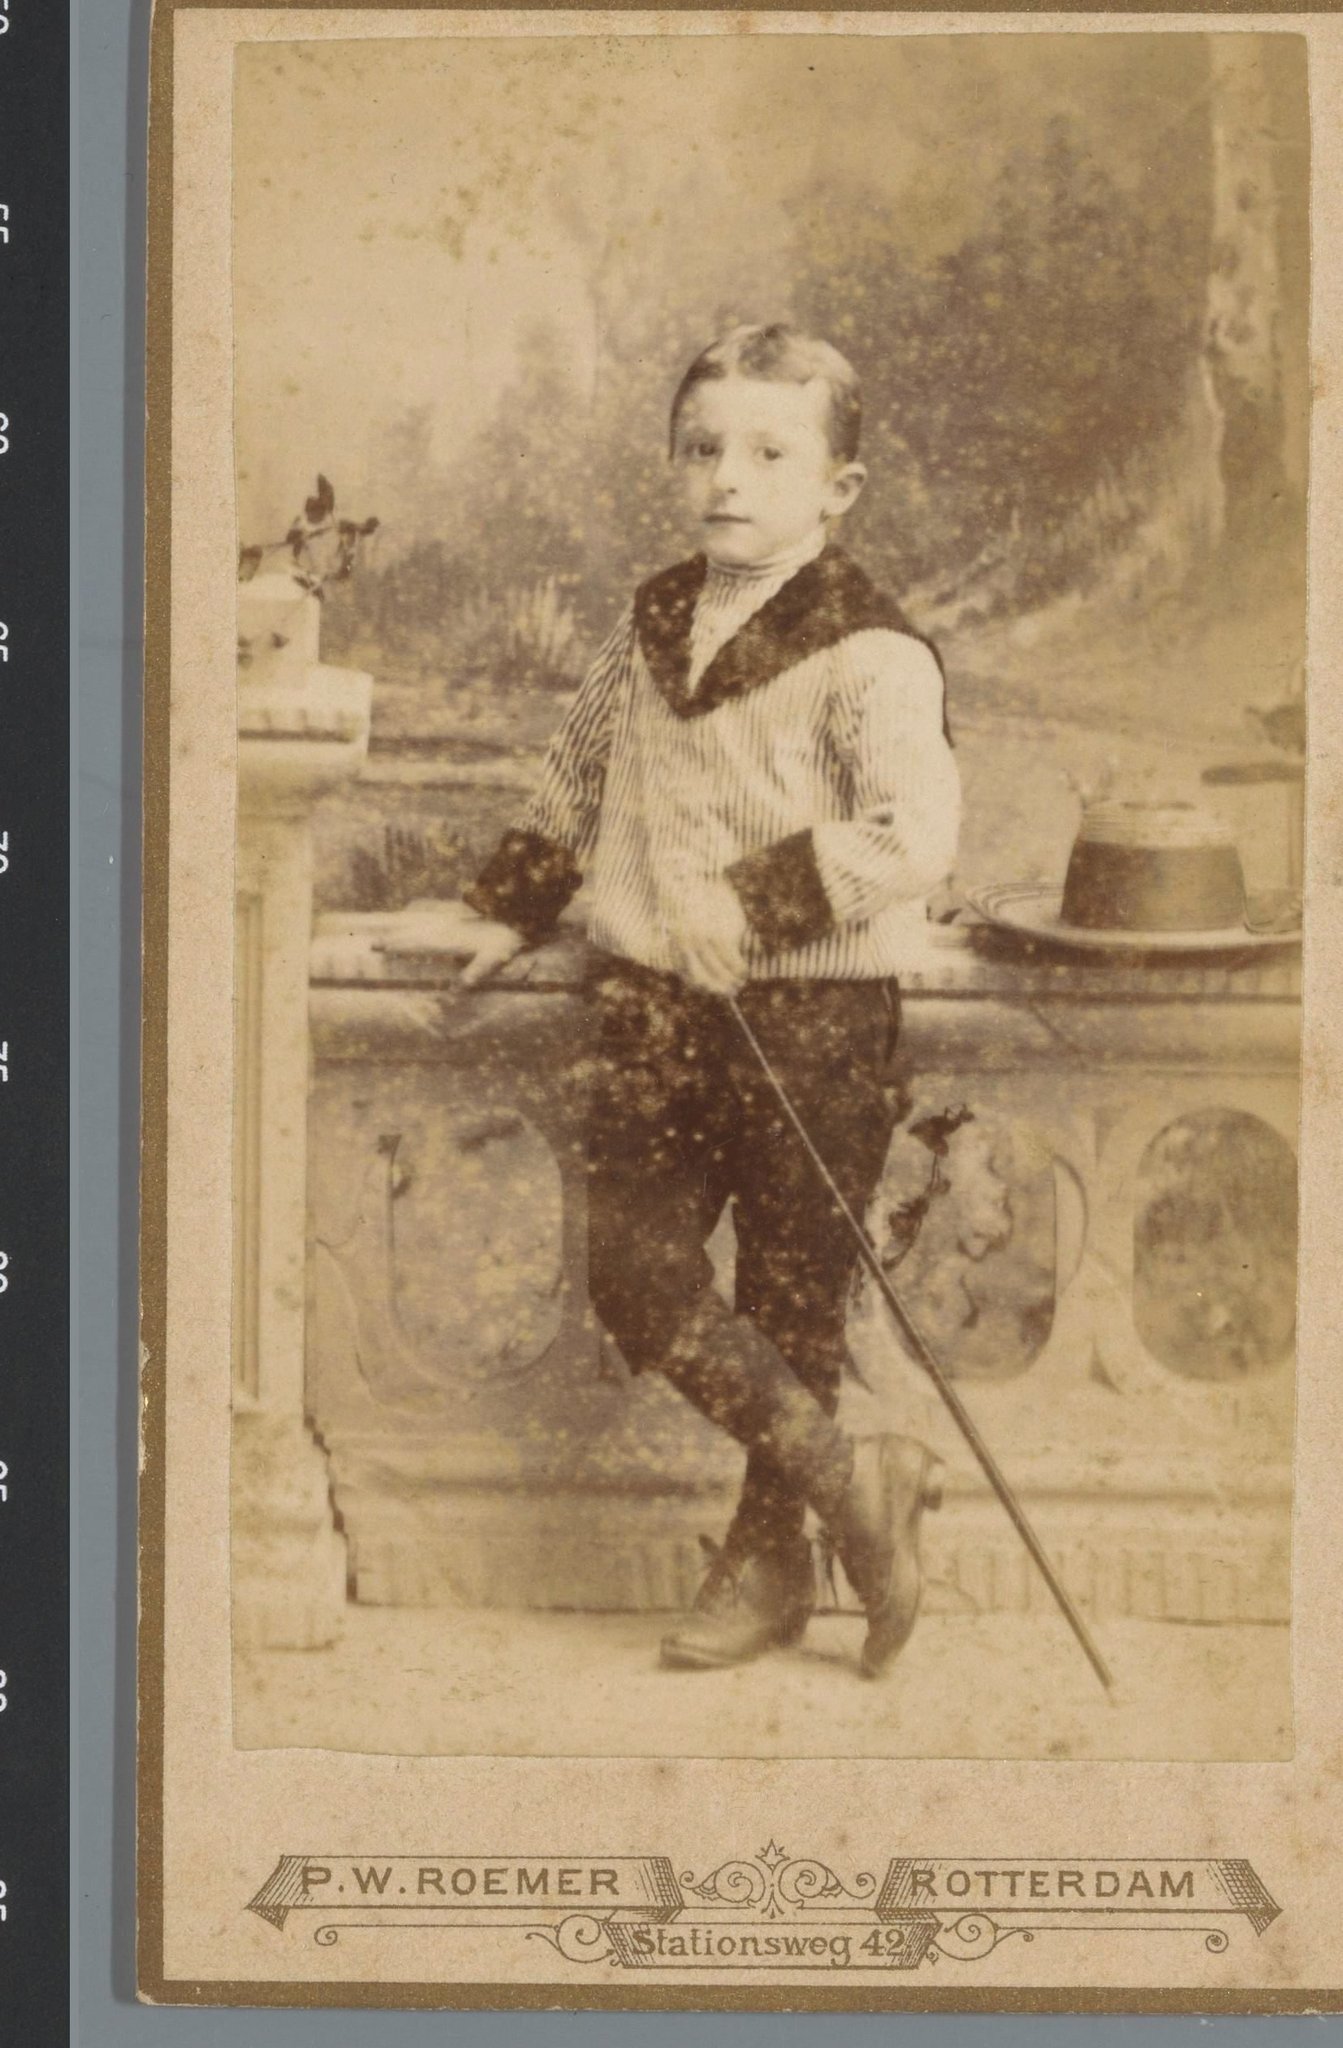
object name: photograph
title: Portret van een onbekende jongen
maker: pieter wilhelmus roemer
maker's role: fotograaf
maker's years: 1838-1924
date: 1891-1910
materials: cardboard, paper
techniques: albumen print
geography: rotterdam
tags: boy (child between toddler and youth), historical persons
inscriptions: inscription: ‘P. W. Roemer/ ROTTERDAM/ Stationsweg 42./ Muster geschützt 25’